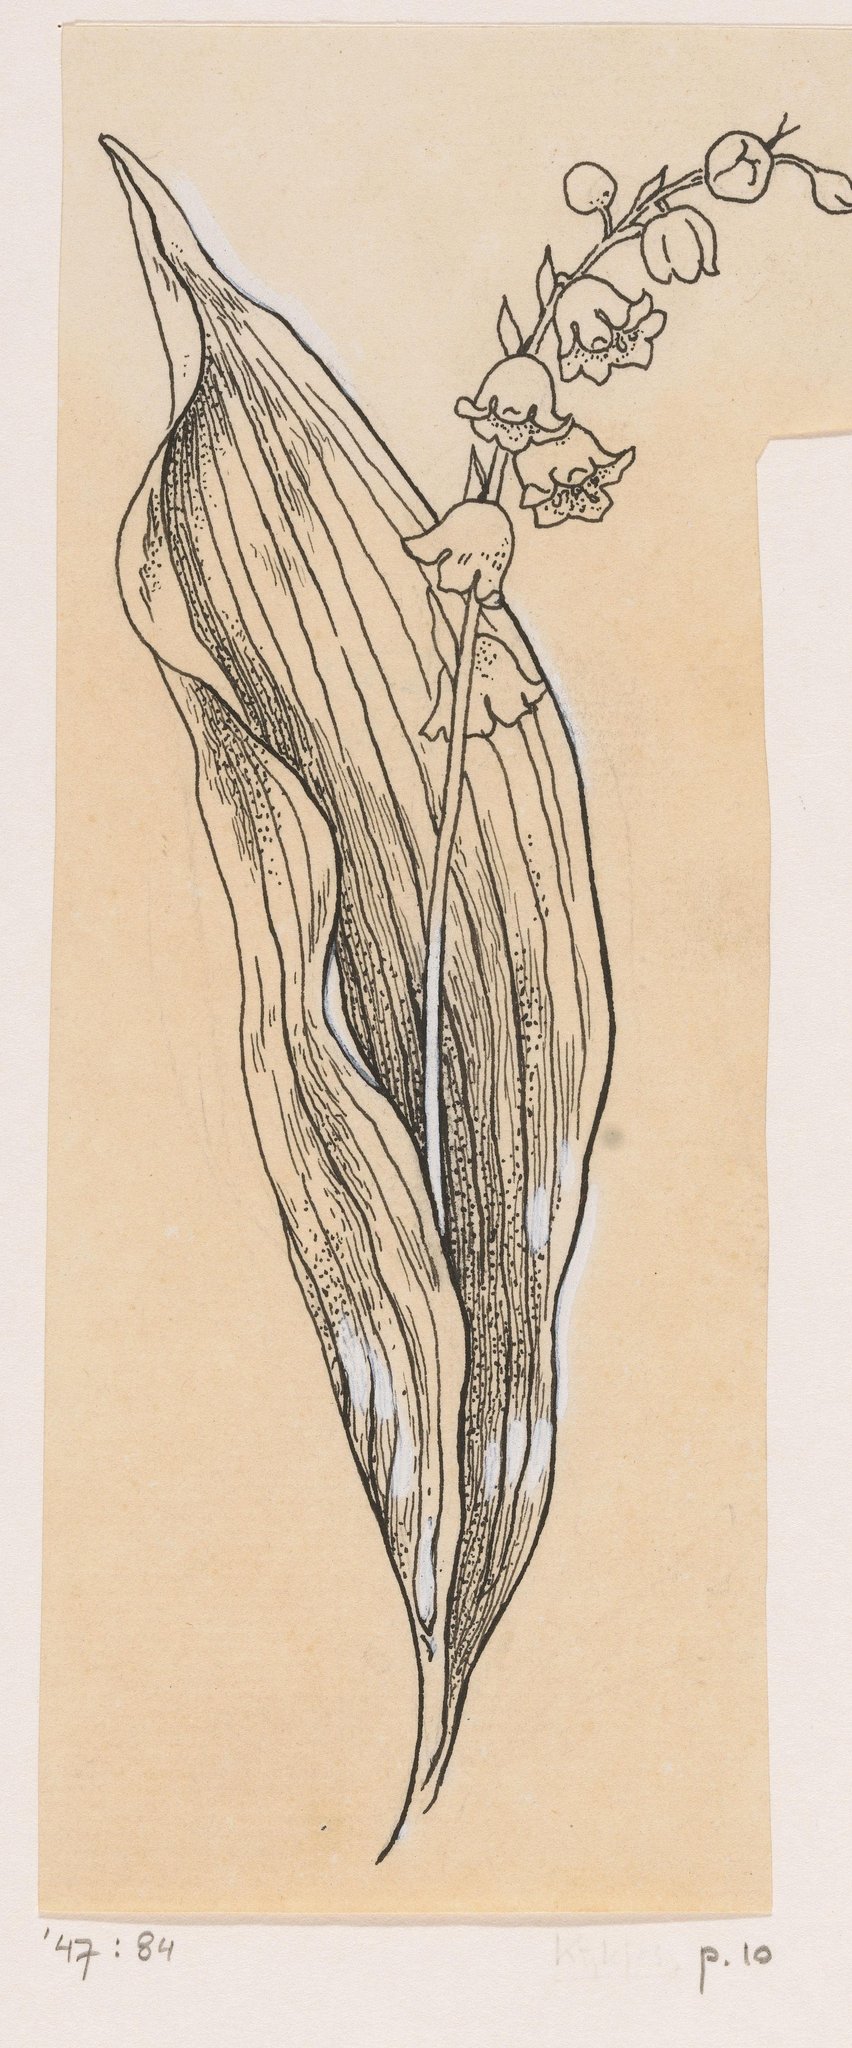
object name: boekillustratie ontwerp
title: Lelietje der dalen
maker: willem wenckebach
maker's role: designer, draughtsman, painter, print maker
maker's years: 1860-1937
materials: paint, ink, paper, pencil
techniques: brush, pen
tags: flowers: lily of the valley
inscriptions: collector's mark: Lugt 2228a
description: Ontwerp voor: Knappert, Emilie C. Kijkjes in de plantenwereld. Loman & Funke: Amsterdam, 1893.